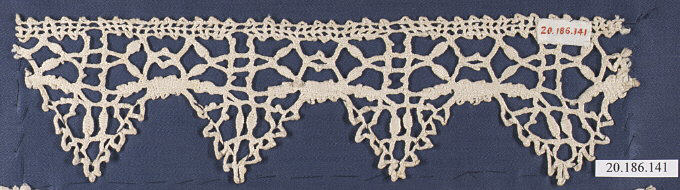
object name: edging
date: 1601-1700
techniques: lace